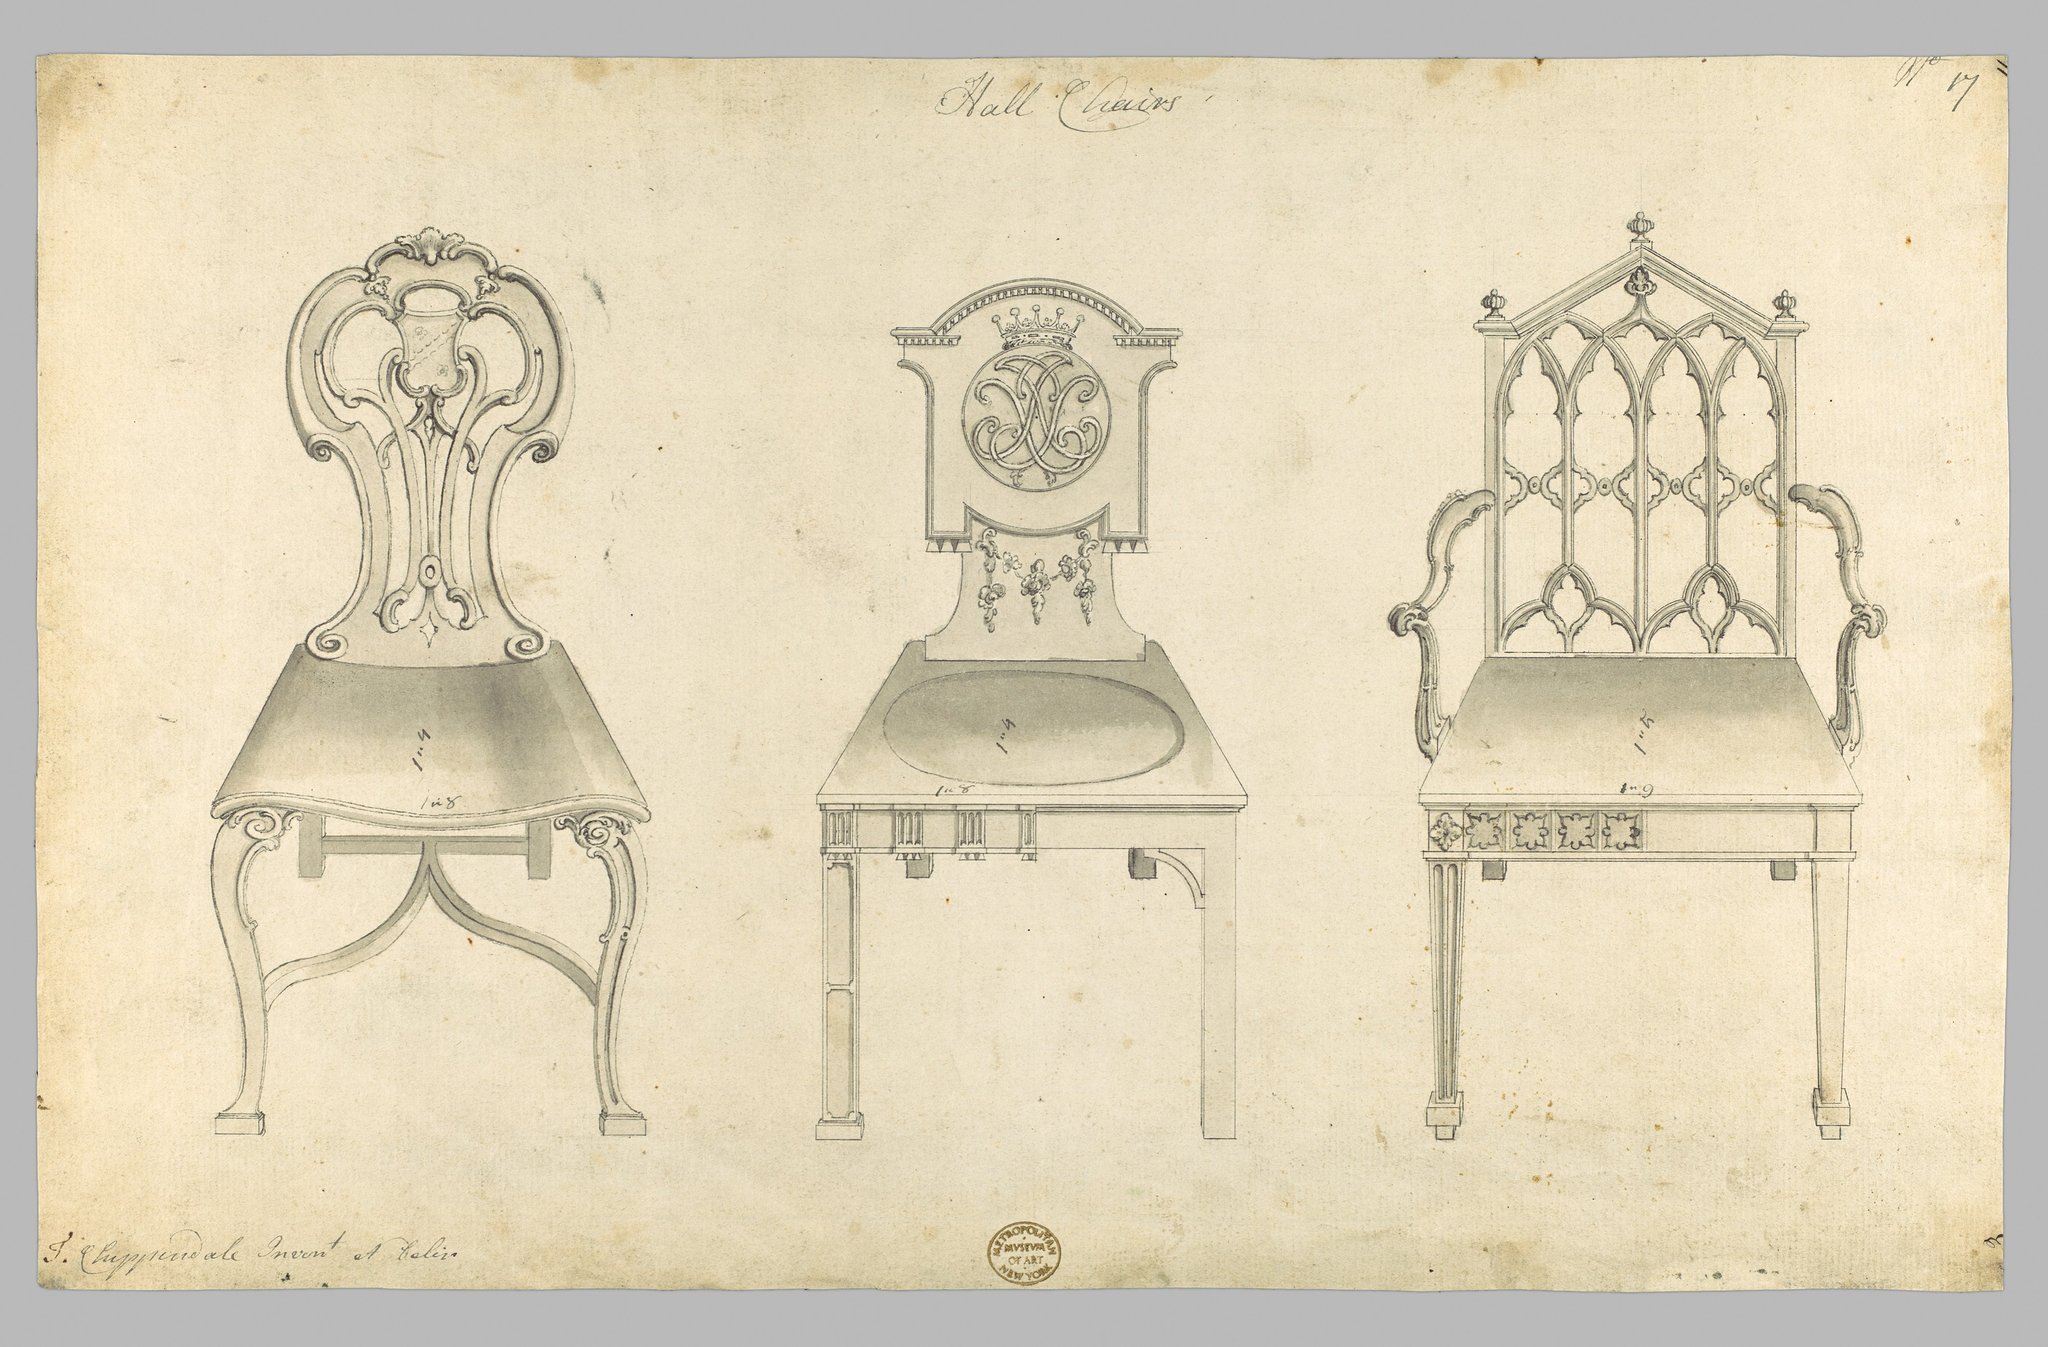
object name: drawing ornament architecture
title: Hall Chairs, in Chippendale Drawings, Vol. I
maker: thomas chippendale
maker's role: artist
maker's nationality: british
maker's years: 1718-1779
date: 1759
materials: ink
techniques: wash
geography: london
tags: chairs